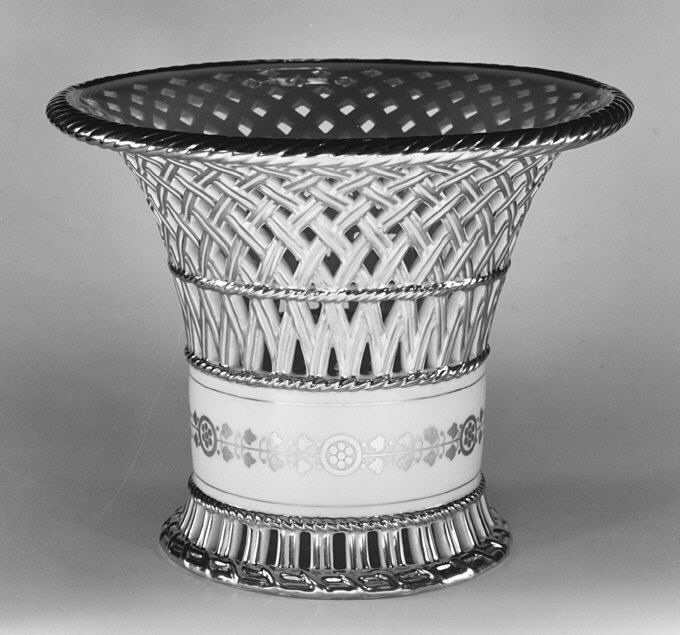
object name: fruit basket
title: Fruit basket (one of a pair)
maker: sèvres manufactory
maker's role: manufactory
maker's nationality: french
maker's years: 1740-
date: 1829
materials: hard paste porcelain